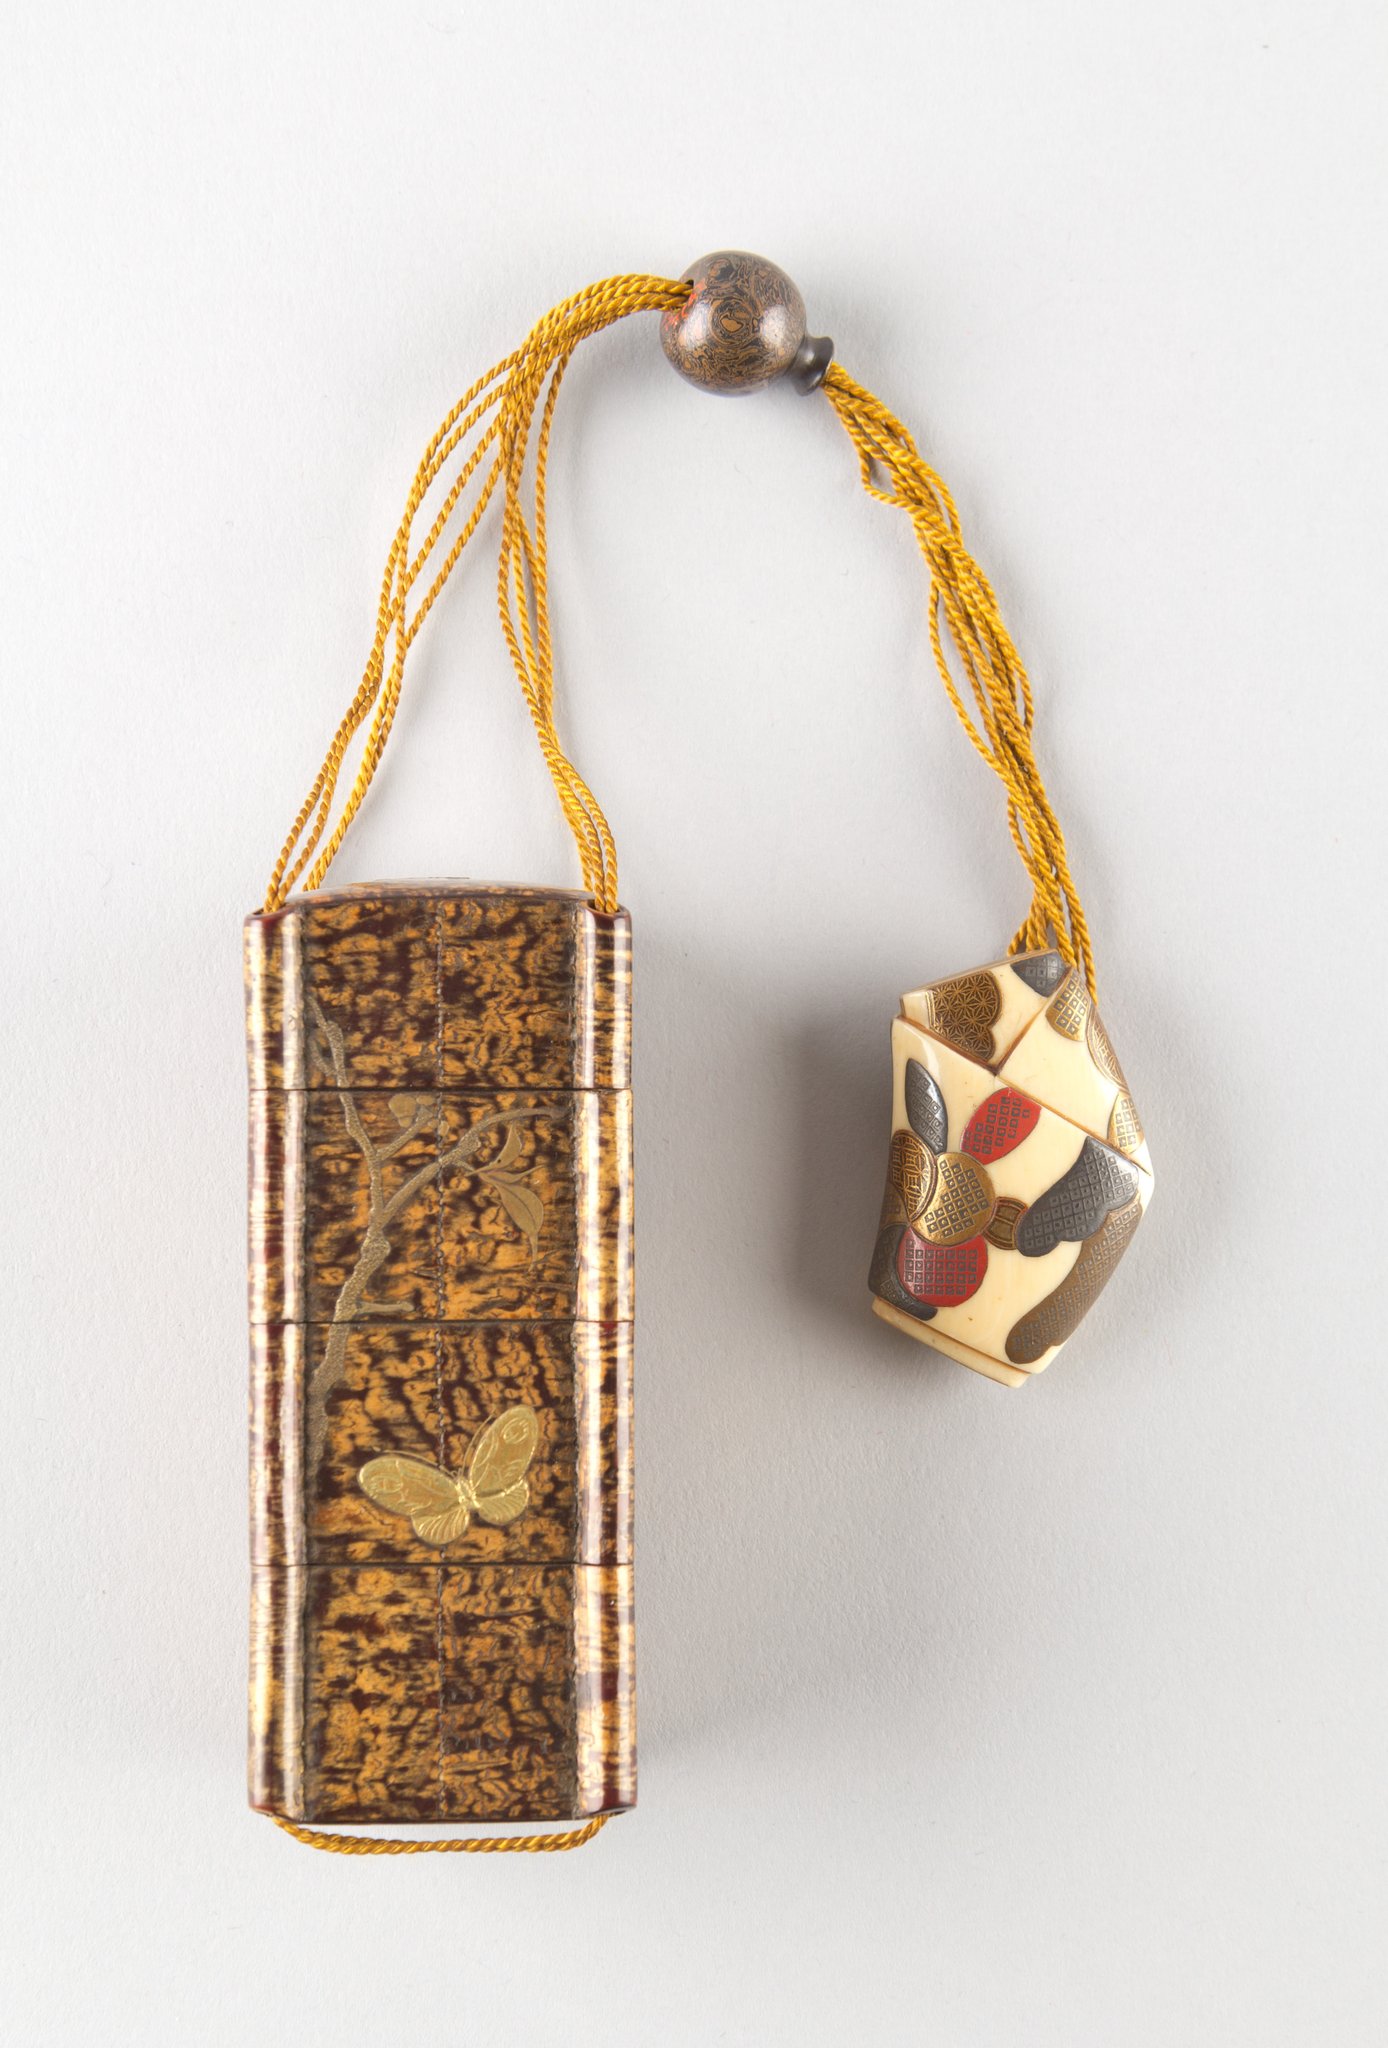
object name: inrō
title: Case (Inrō) in the Shape of Tiered Picnic Box of Cherry Bark with Cherry Blossoms and Butterfly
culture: japanese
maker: kiyokawa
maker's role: artist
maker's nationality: japanese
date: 1701-1800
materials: foil, gold, ivory, lacquer, metal, silver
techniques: maki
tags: butterflies,trees